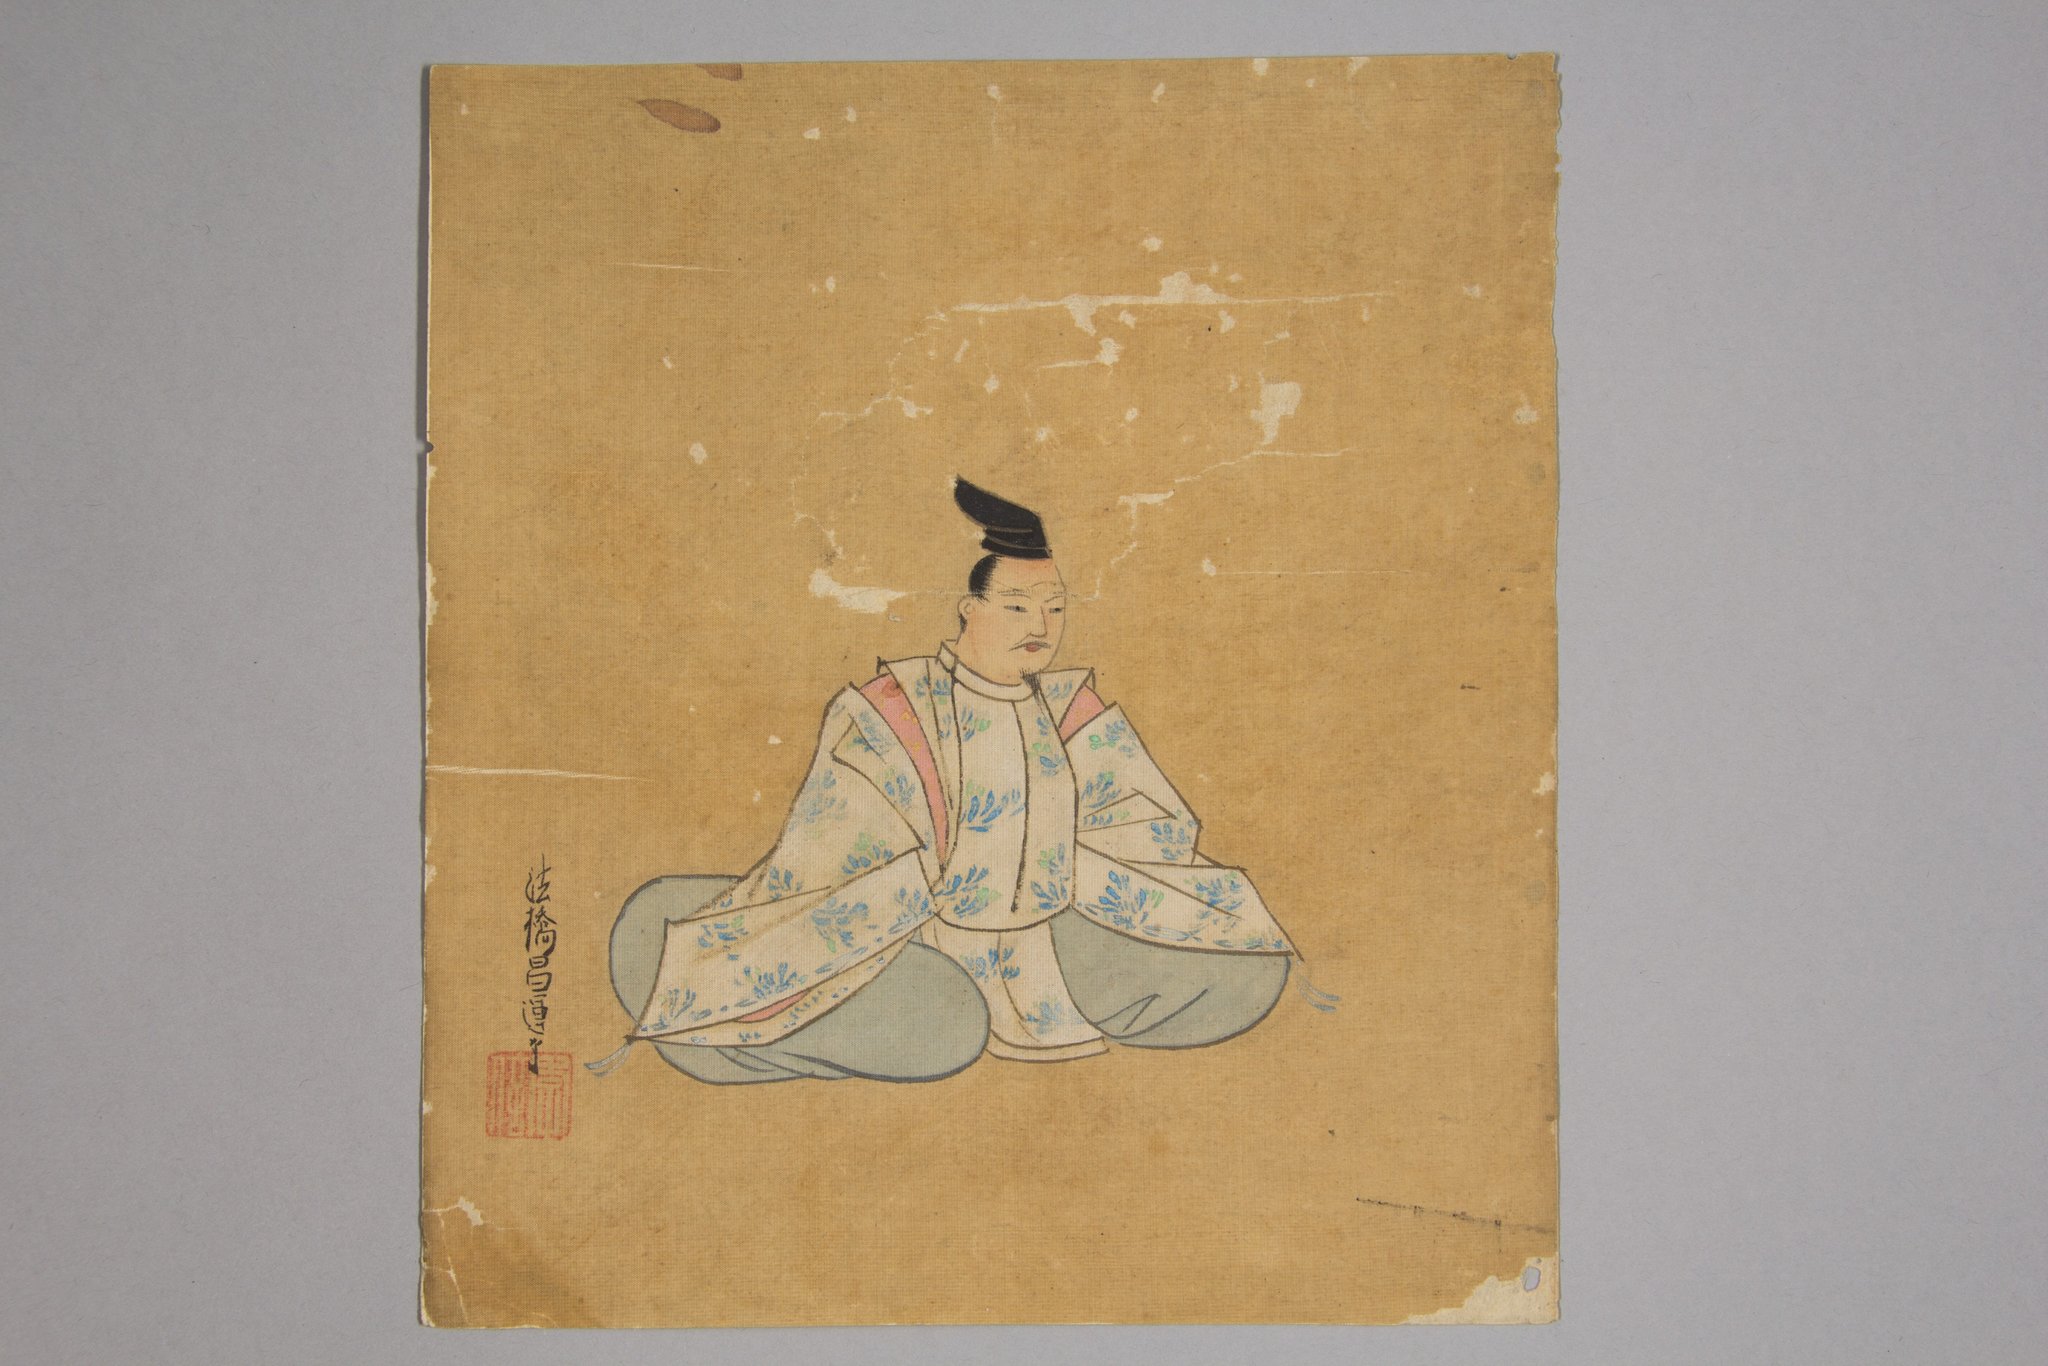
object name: painting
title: Immortal Poet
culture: japanese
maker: kano shōun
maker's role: artist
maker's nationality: japanese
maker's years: 1637-1702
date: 1601-1700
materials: ink, silk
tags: men,poets